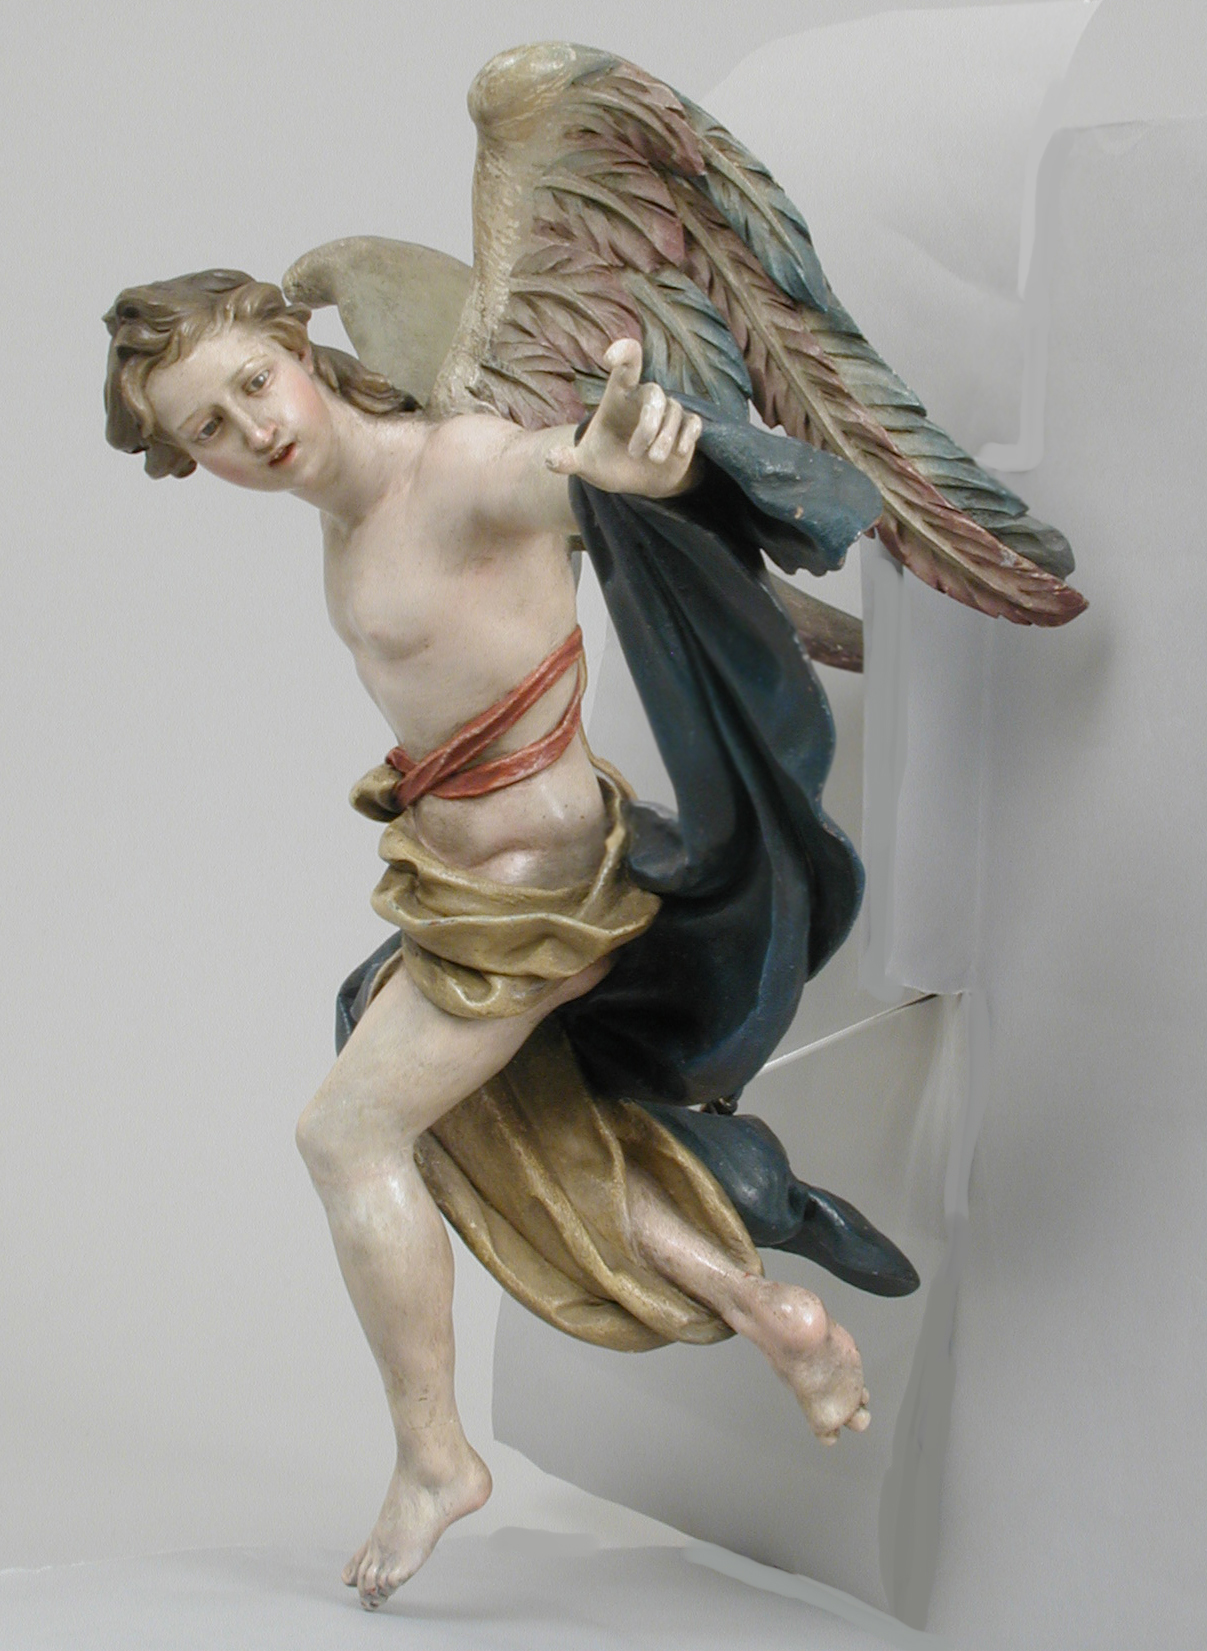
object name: crèche figure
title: Angel: Saint Michael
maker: francesco celebrano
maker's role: maker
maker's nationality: italian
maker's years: 1729-1814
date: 1701-1900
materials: terracotta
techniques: polychrome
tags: angels,saint michael